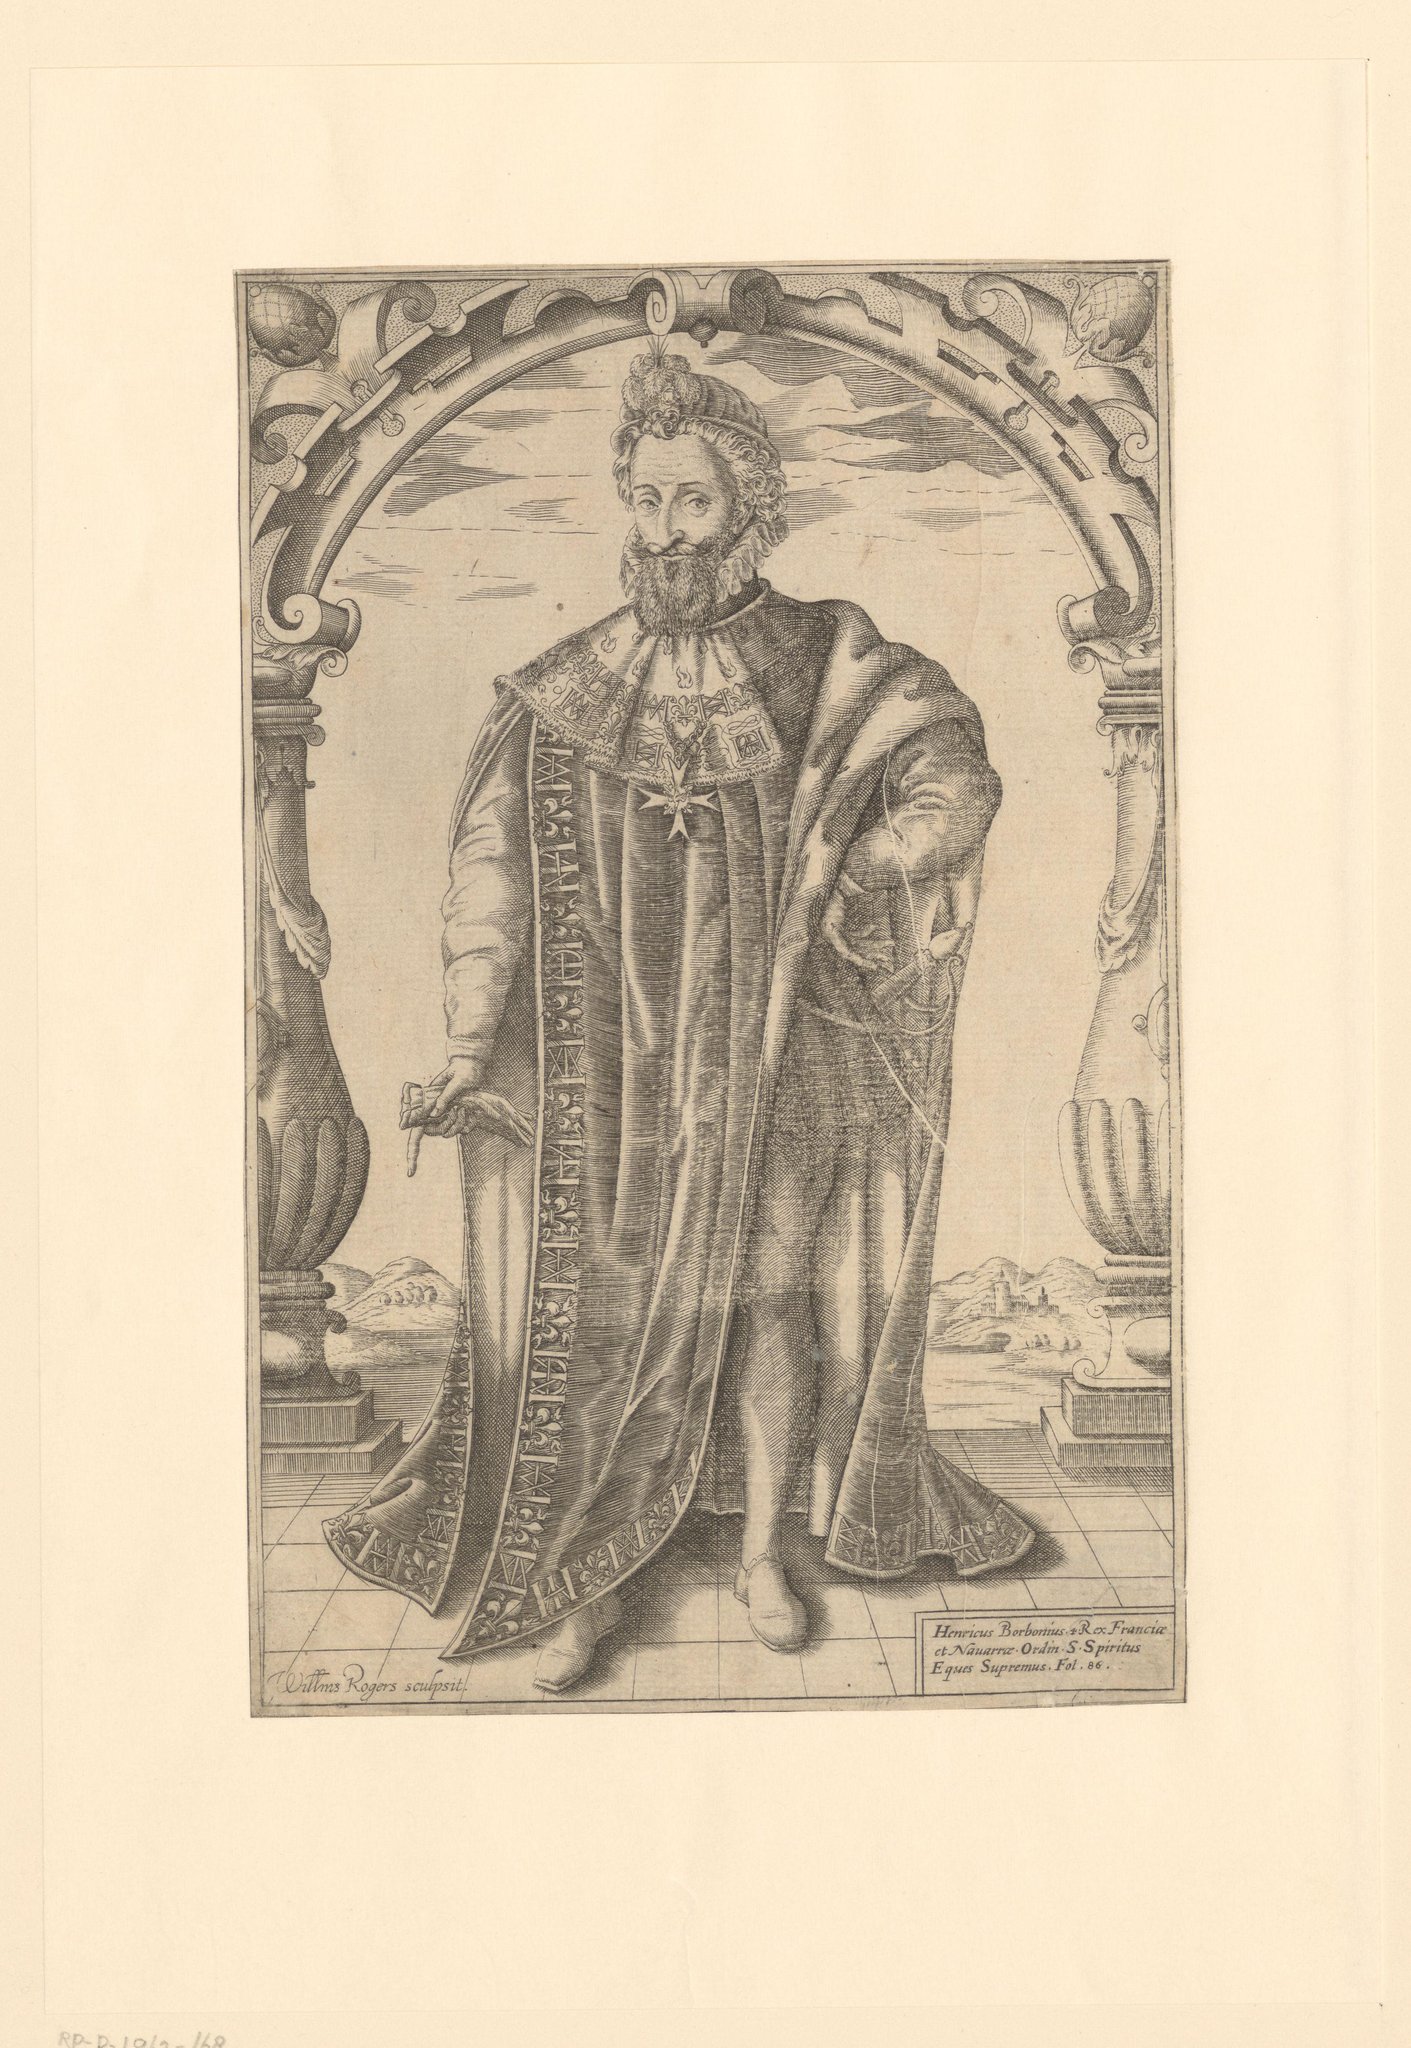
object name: print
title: Portret van Hendrik V, koning van Engeland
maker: william rogers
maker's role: print maker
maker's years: 1545-1604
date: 1589-1602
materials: paper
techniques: engraving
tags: historical persons, king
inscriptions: collector's mark: Lugt 2228, collector's mark: Lugt 2760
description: Prent gebruikt in: Segar, William. Honor Military, and Civill. Londen: Robert Barker, 1602.